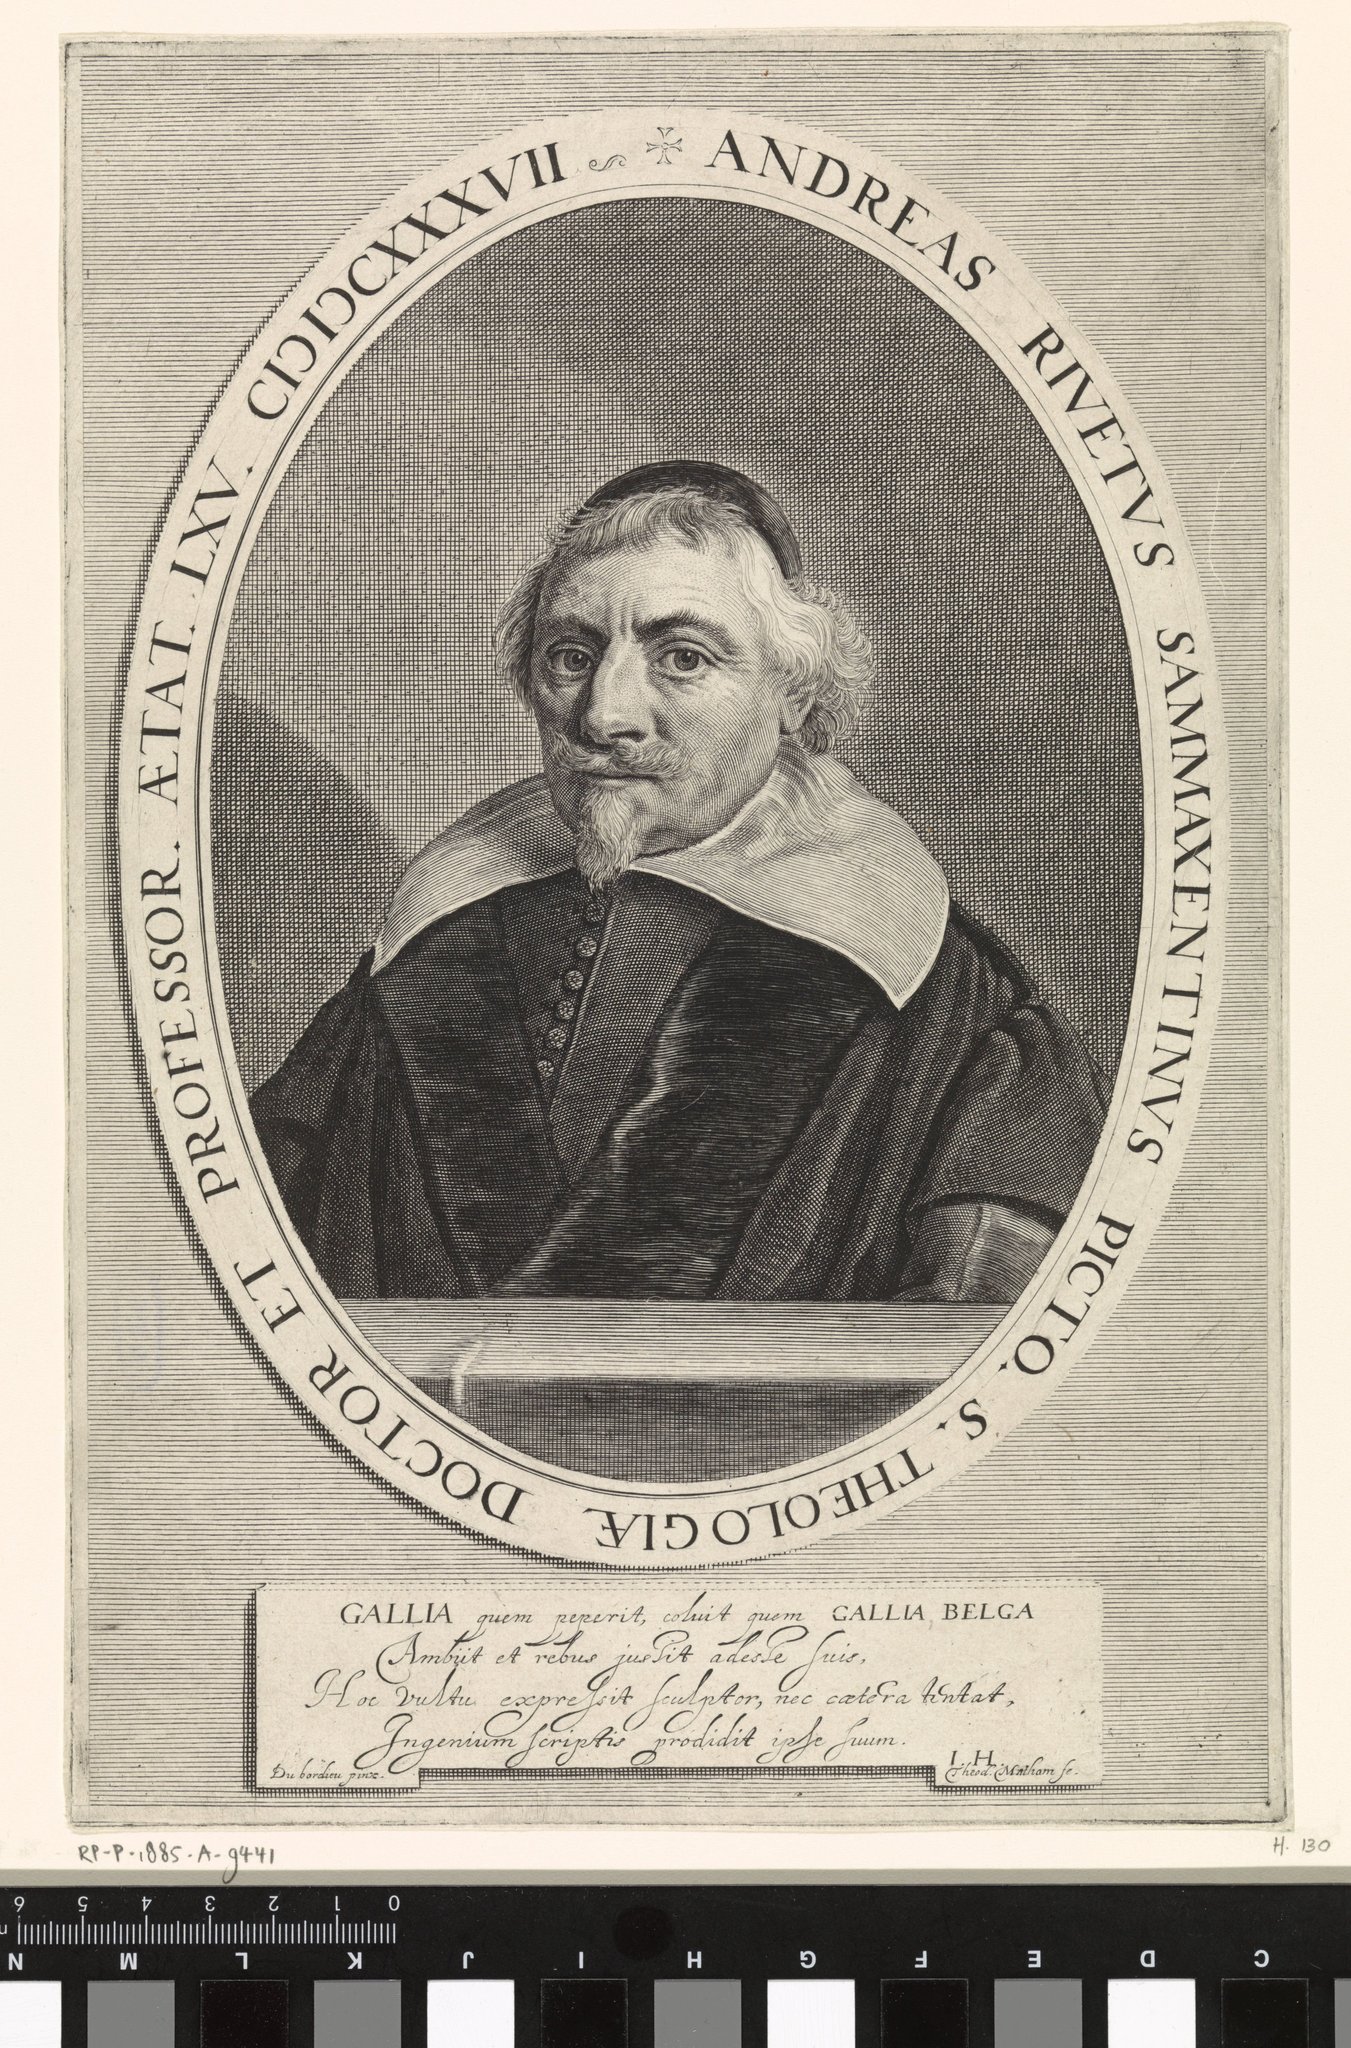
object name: print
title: Portret van André Rivet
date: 1637-1676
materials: paper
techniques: engraving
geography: northern netherlands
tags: andré rivet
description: Portret van André Rivet, hoogleraar te Leiden.